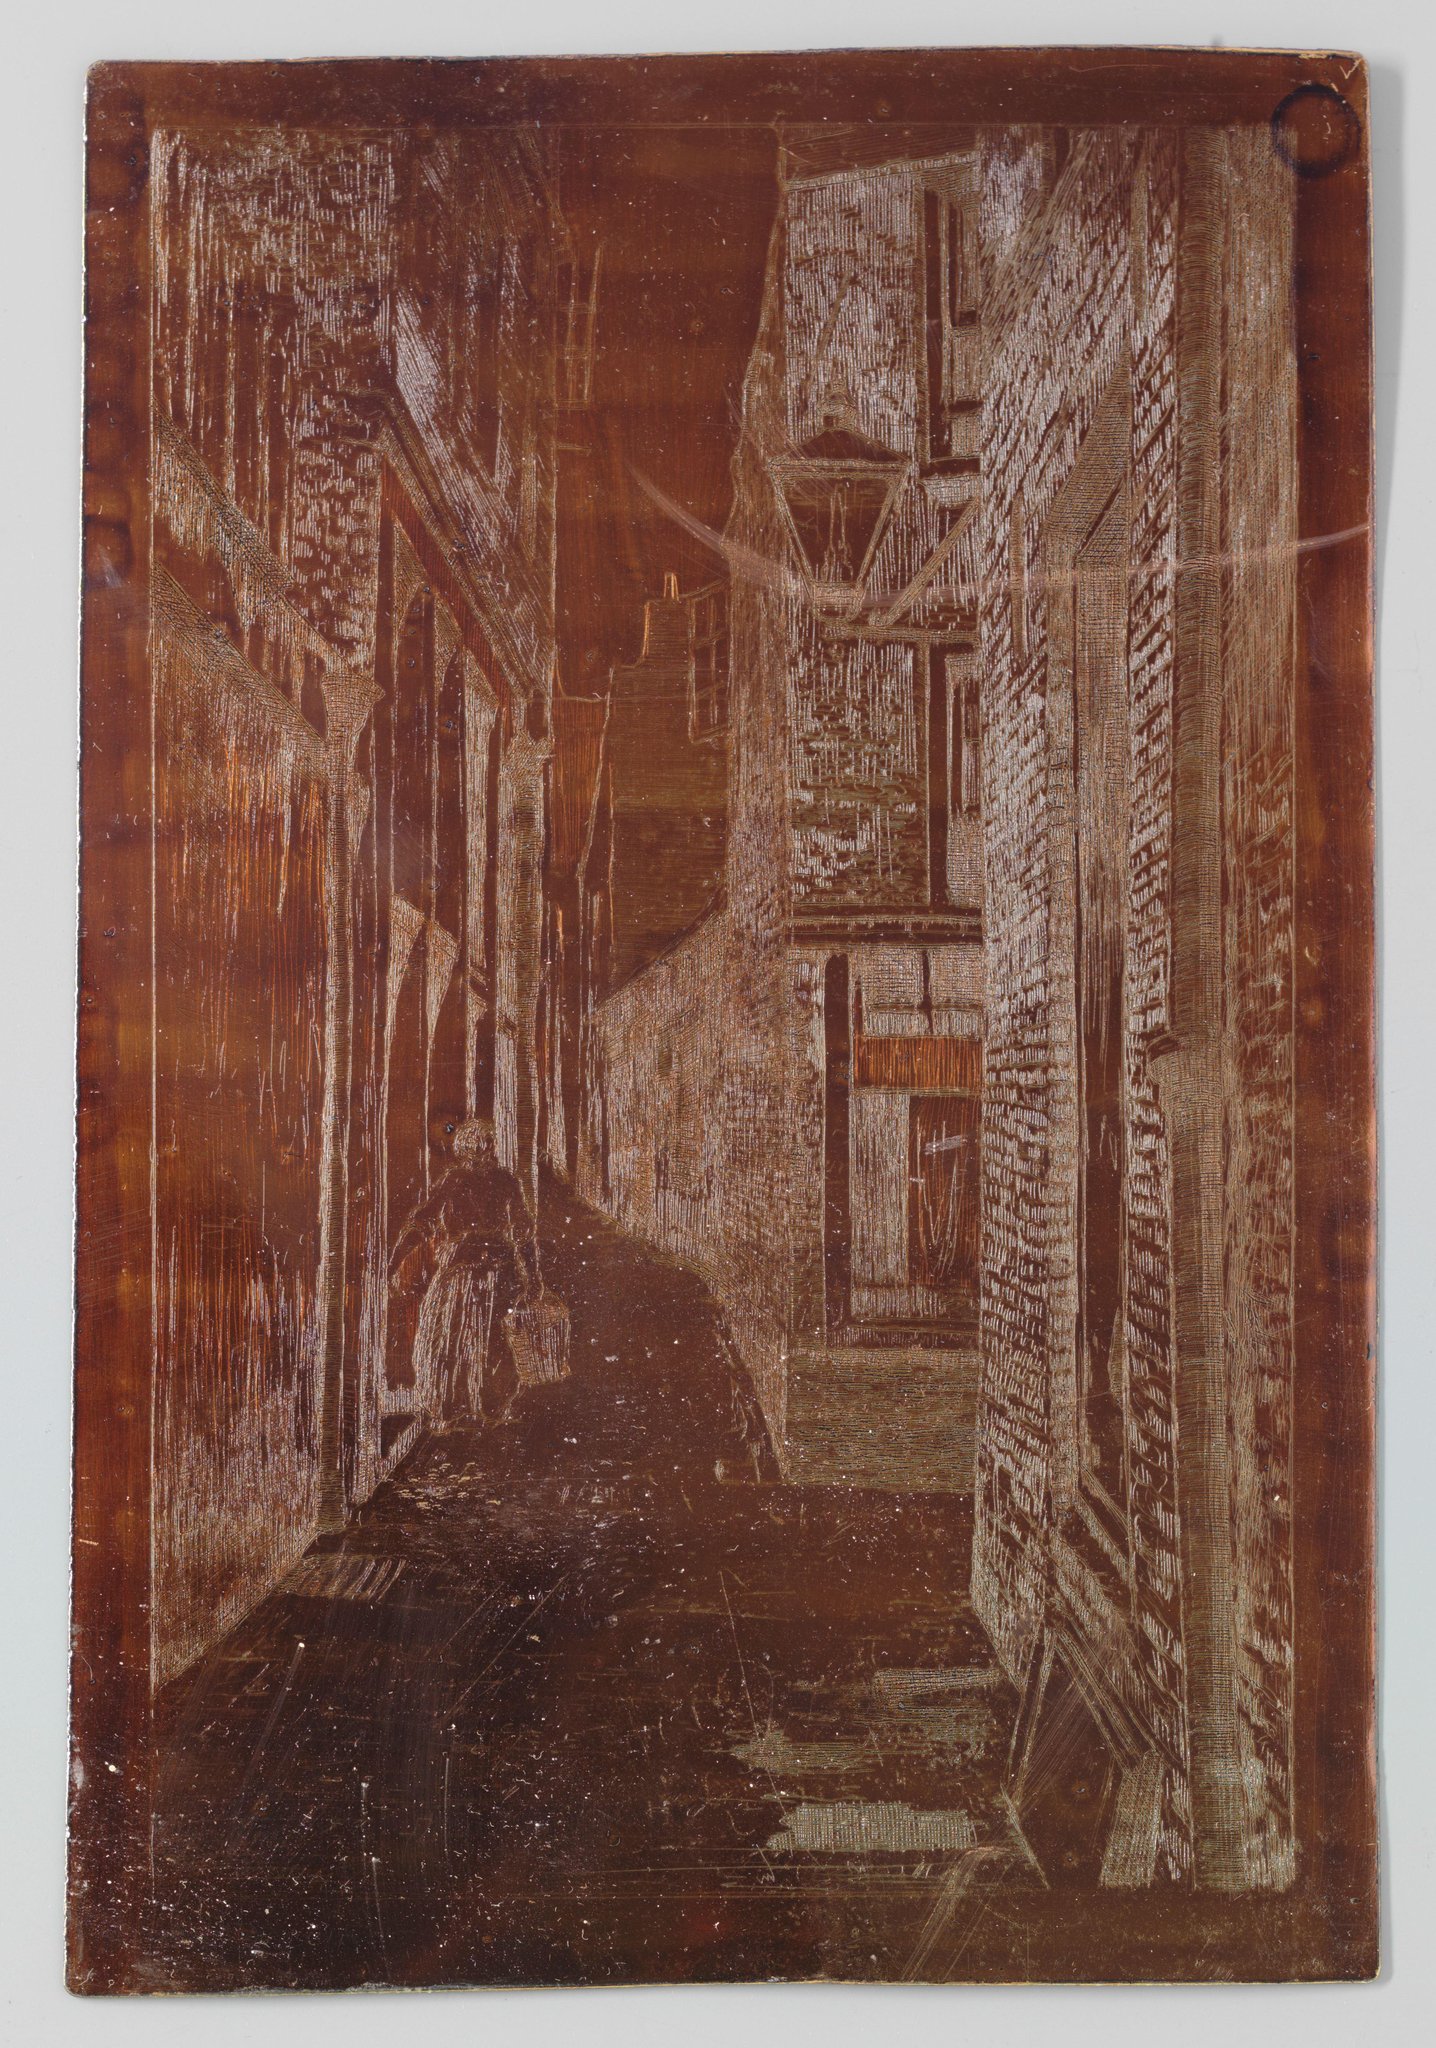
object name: copper plate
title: Oude straat te Rijswijk of Scheveningen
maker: willem adrianus grondhout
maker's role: draughtsman, painter, print maker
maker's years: 1878-1934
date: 1888-1934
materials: copper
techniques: etching